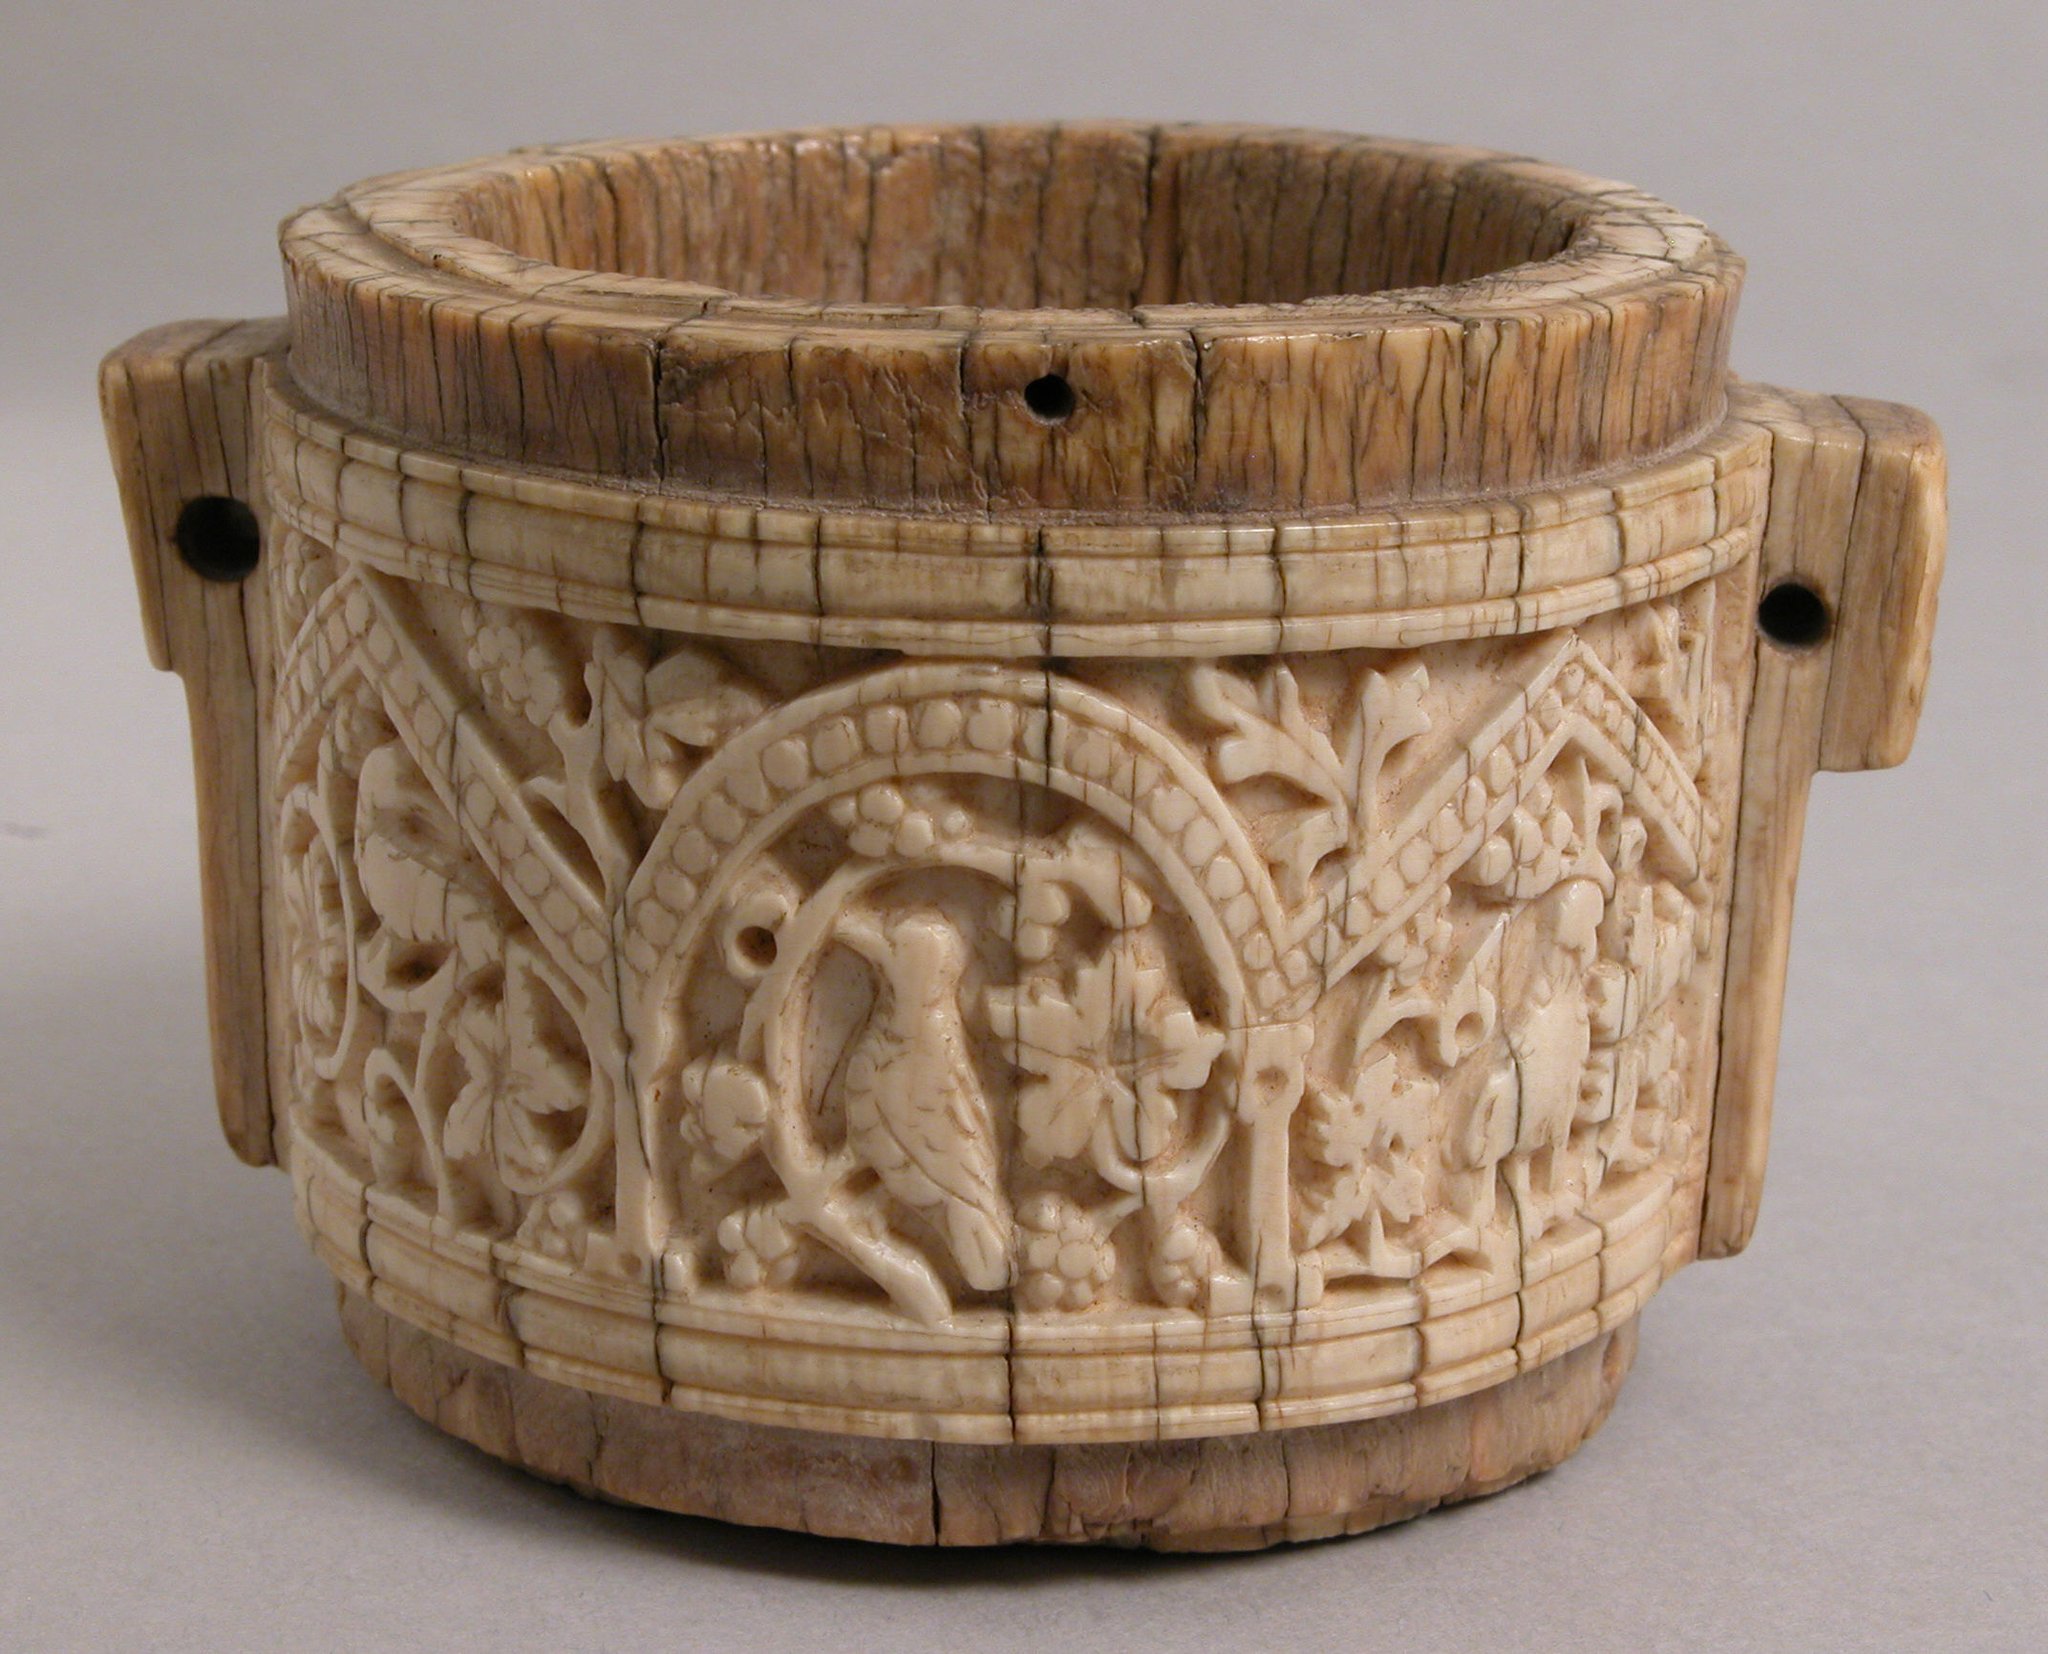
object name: mortar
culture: syrian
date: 900-950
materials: ivory